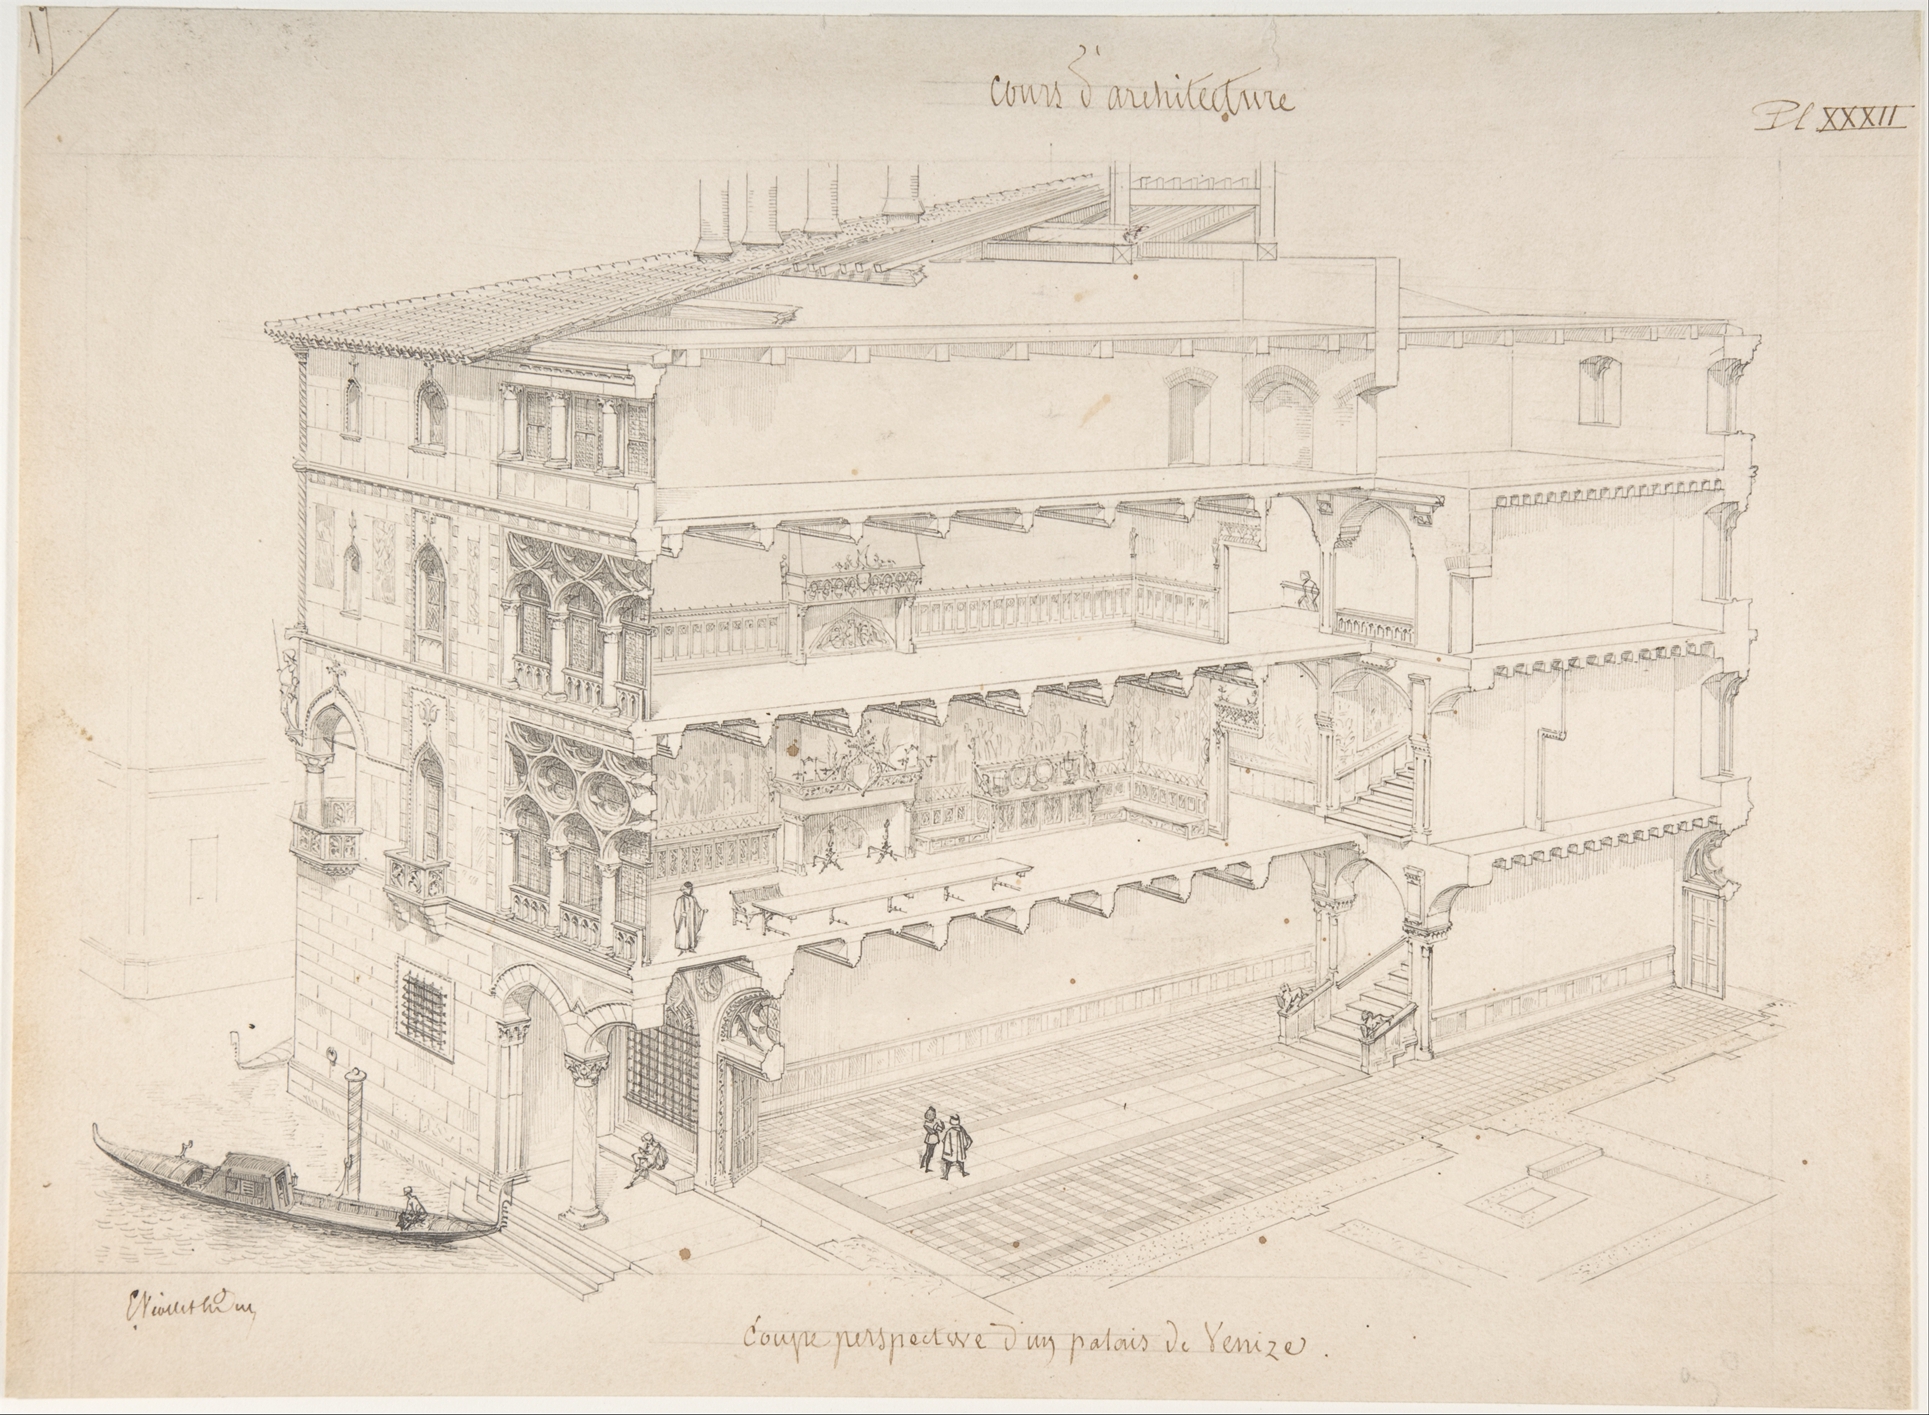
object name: drawing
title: Perspectival Cross-Section of a Venetian Palace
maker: eugène-emmanuel viollet-le-duc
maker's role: artist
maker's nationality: french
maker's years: 1814-1879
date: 1830-1879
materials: ink, metal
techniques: brush, pen, wash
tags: human figures,palaces,boats,venice